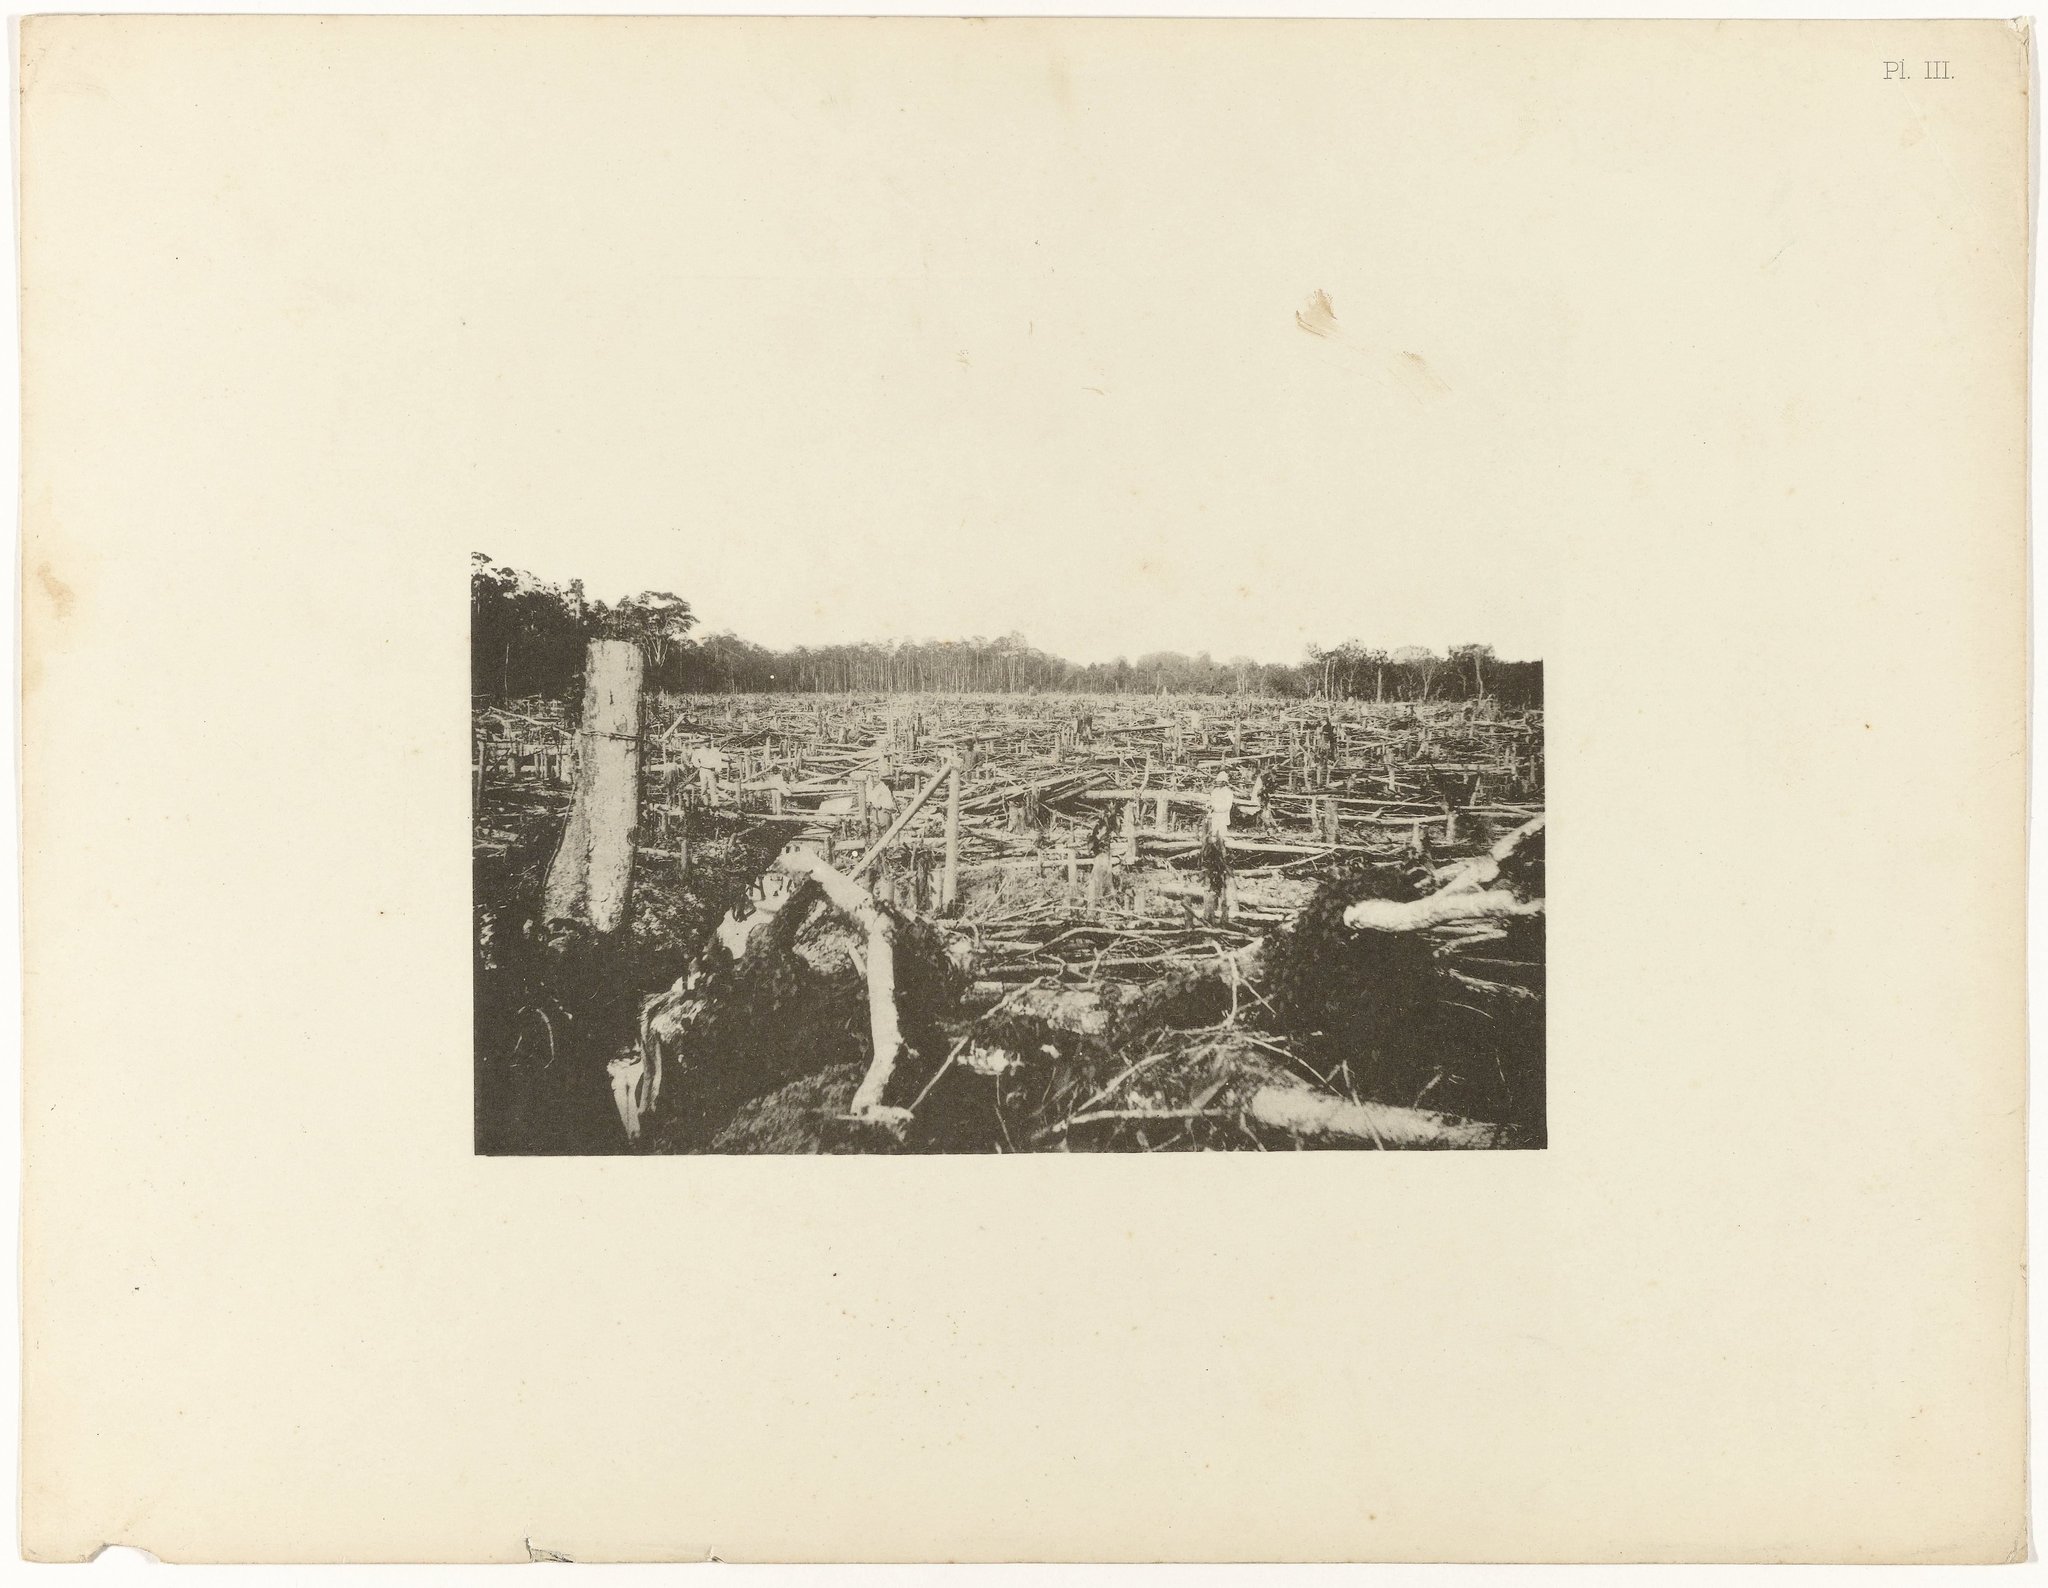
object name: photomechanical print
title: Kolonie Suriname Afbeeldingen betreffende Cultuurgewassen, Plantages, Goudvelden, Volkstypen enz.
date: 1896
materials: paper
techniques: photograph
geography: haarlem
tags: soil cultivation, cultivated land, suriname